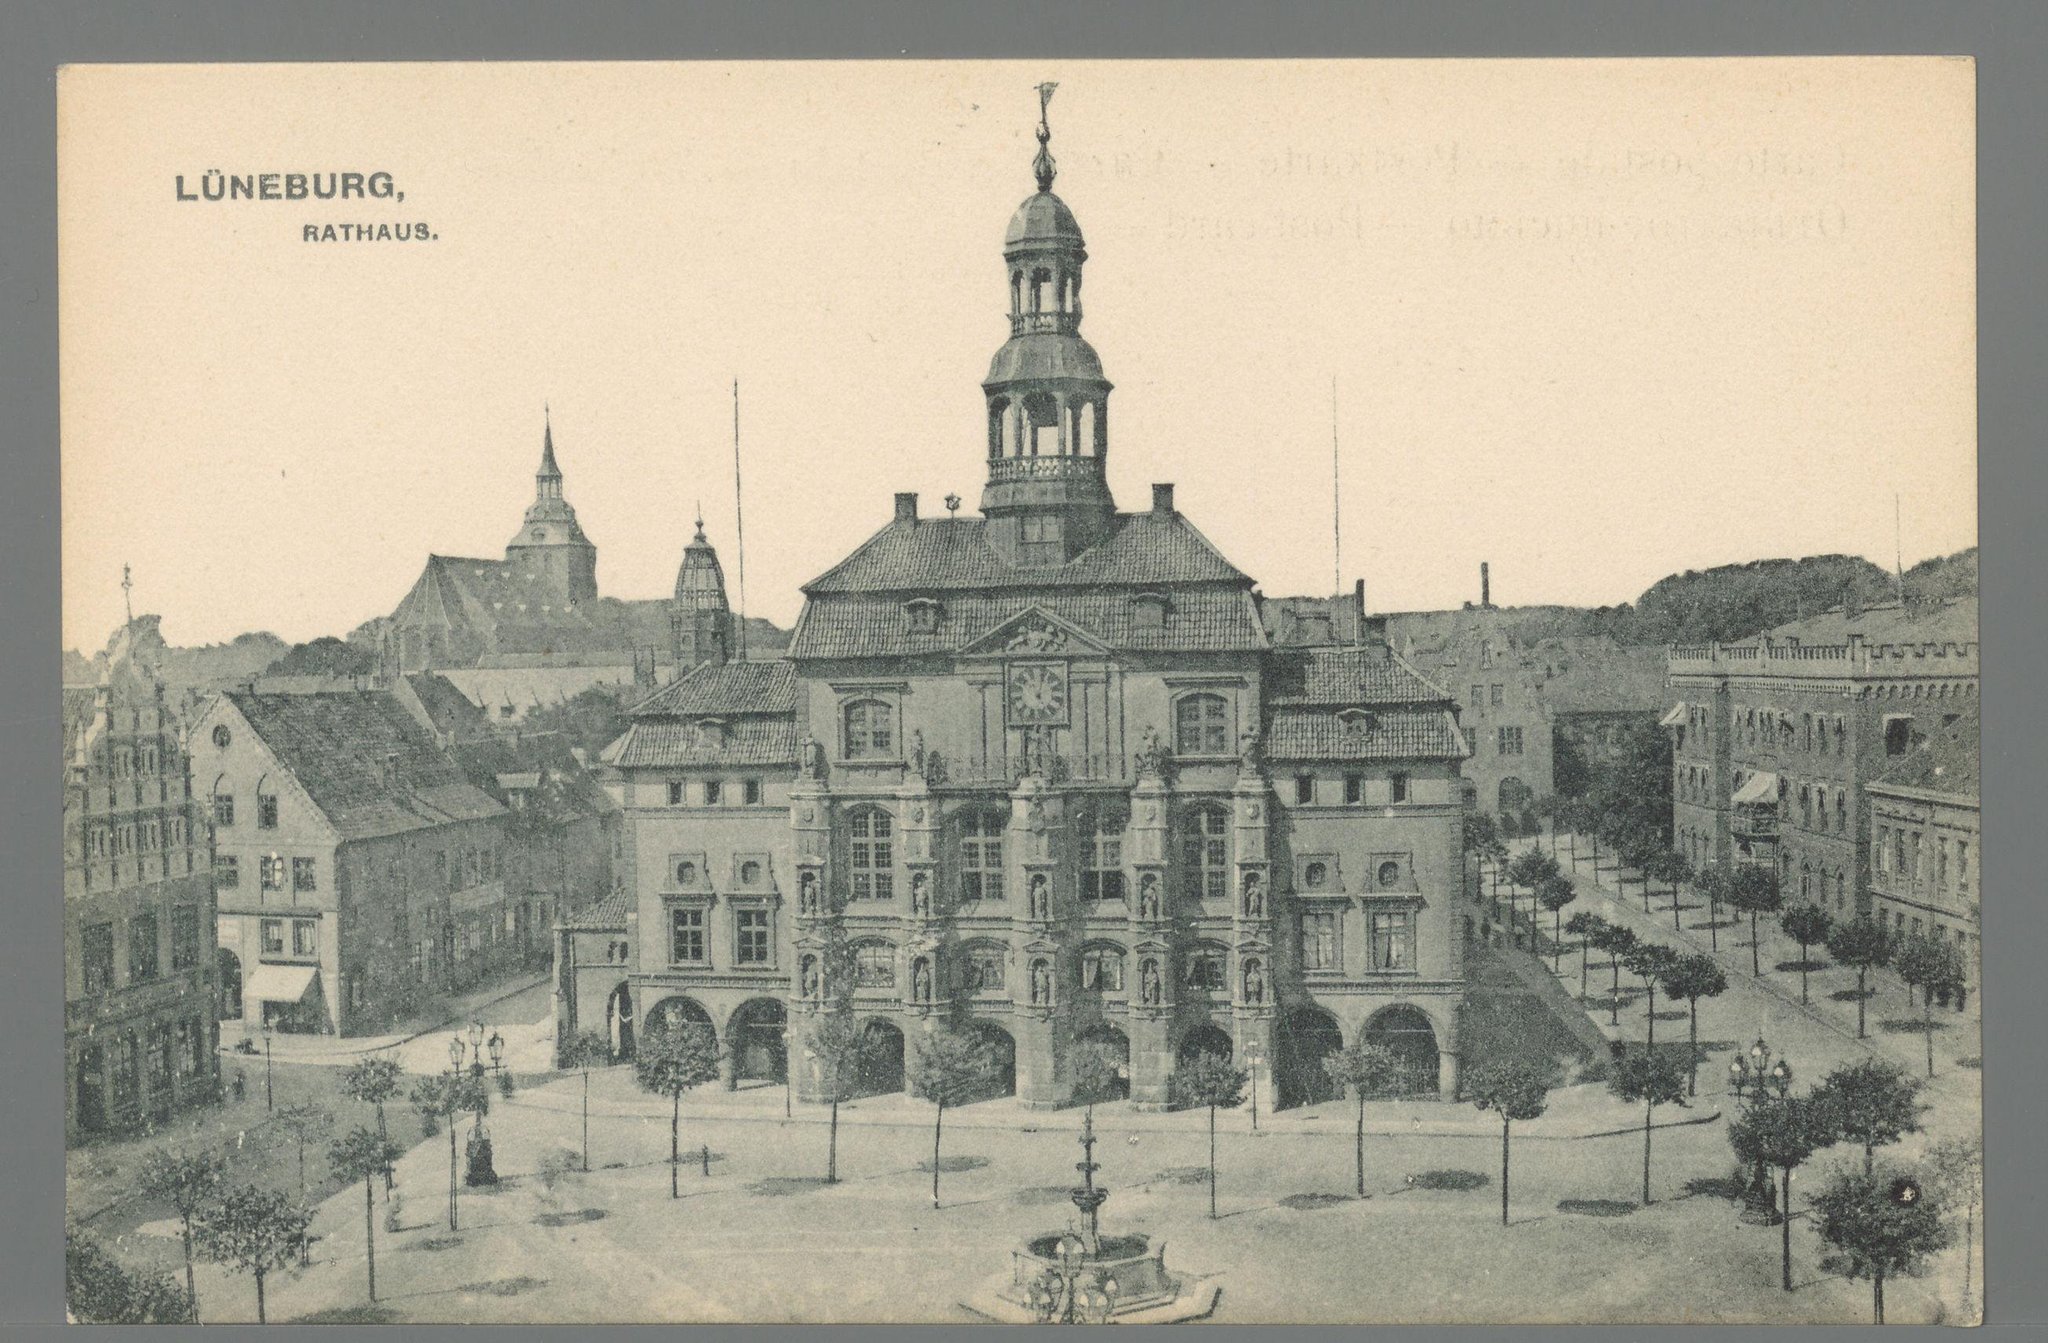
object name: photomechanical print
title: Lüneburg, Rathaus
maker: Anonymous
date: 1906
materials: cardboard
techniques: photograph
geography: darmstadt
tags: townhall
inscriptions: date